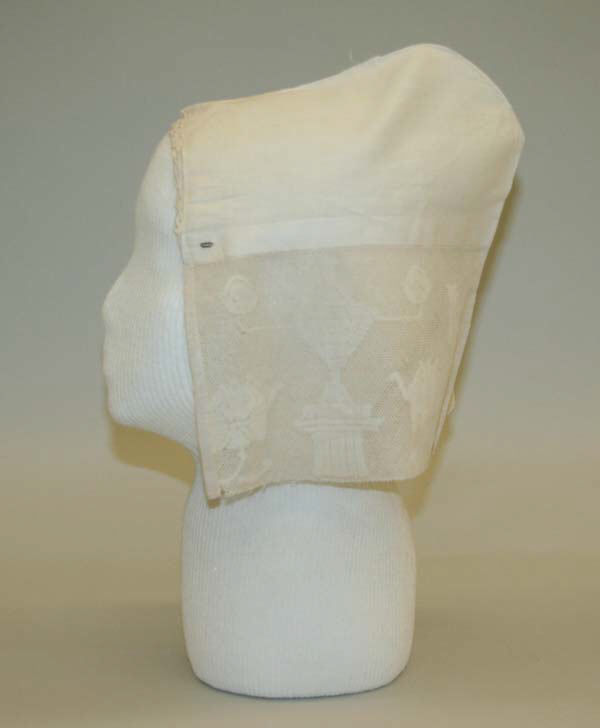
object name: cap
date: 1701-1725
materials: linen